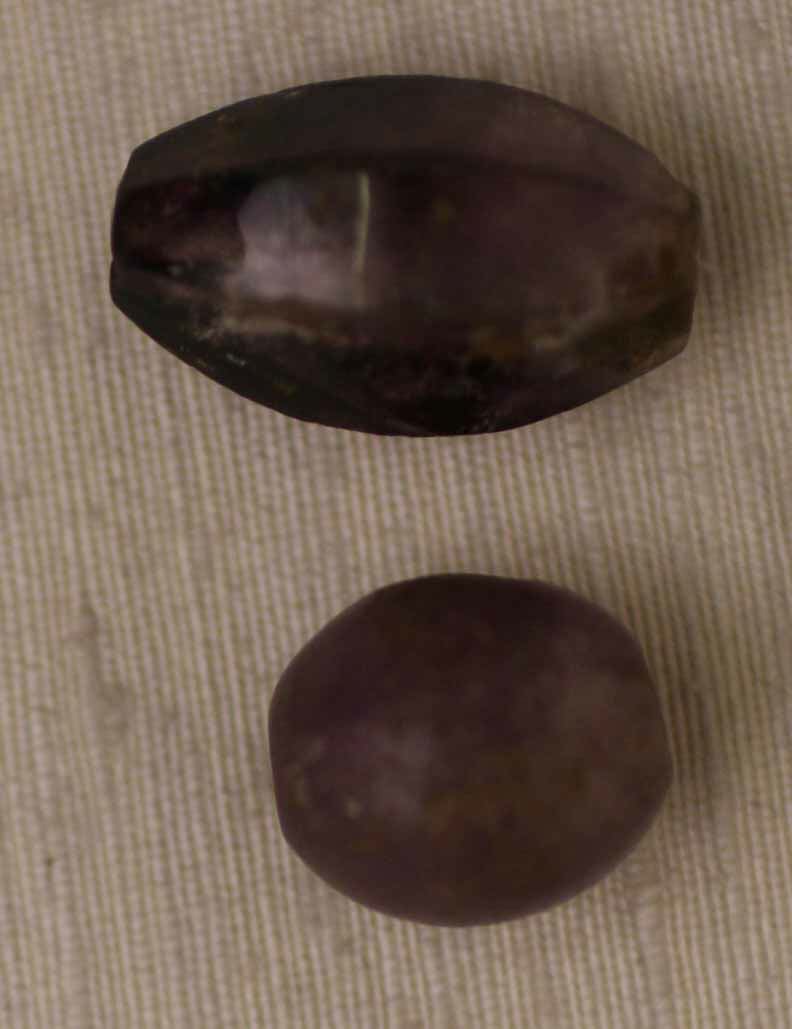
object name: bead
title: Beads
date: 201-1200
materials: gemstone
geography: egypt